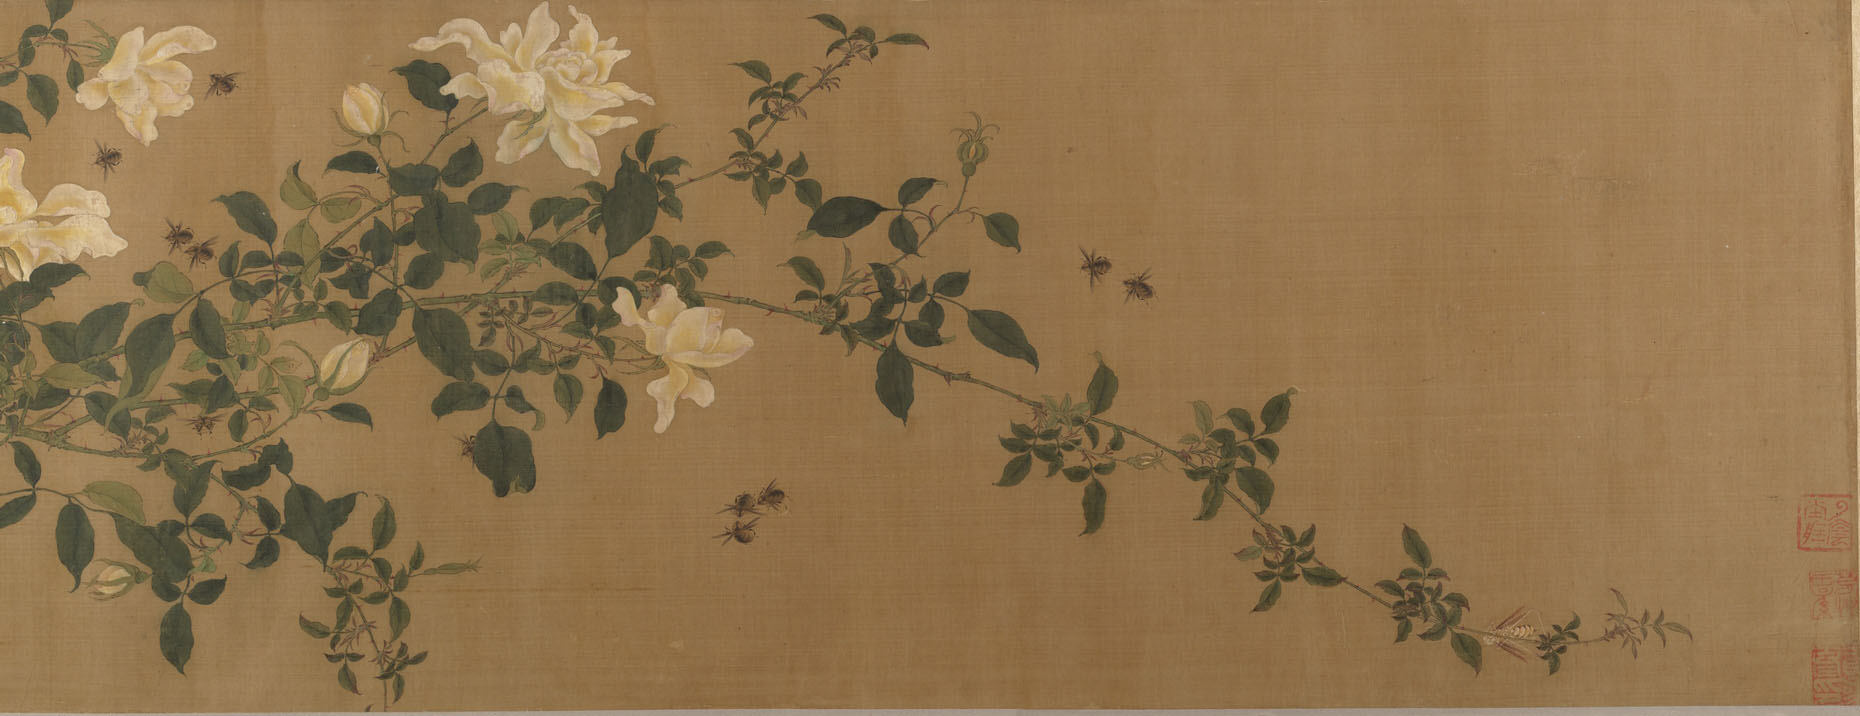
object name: handscroll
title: Yellow Roses and Bees, Pink Roses and Wasps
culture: chinese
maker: unidentified artist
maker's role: artist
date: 1644-1911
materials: ink, silk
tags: insects,bees,roses